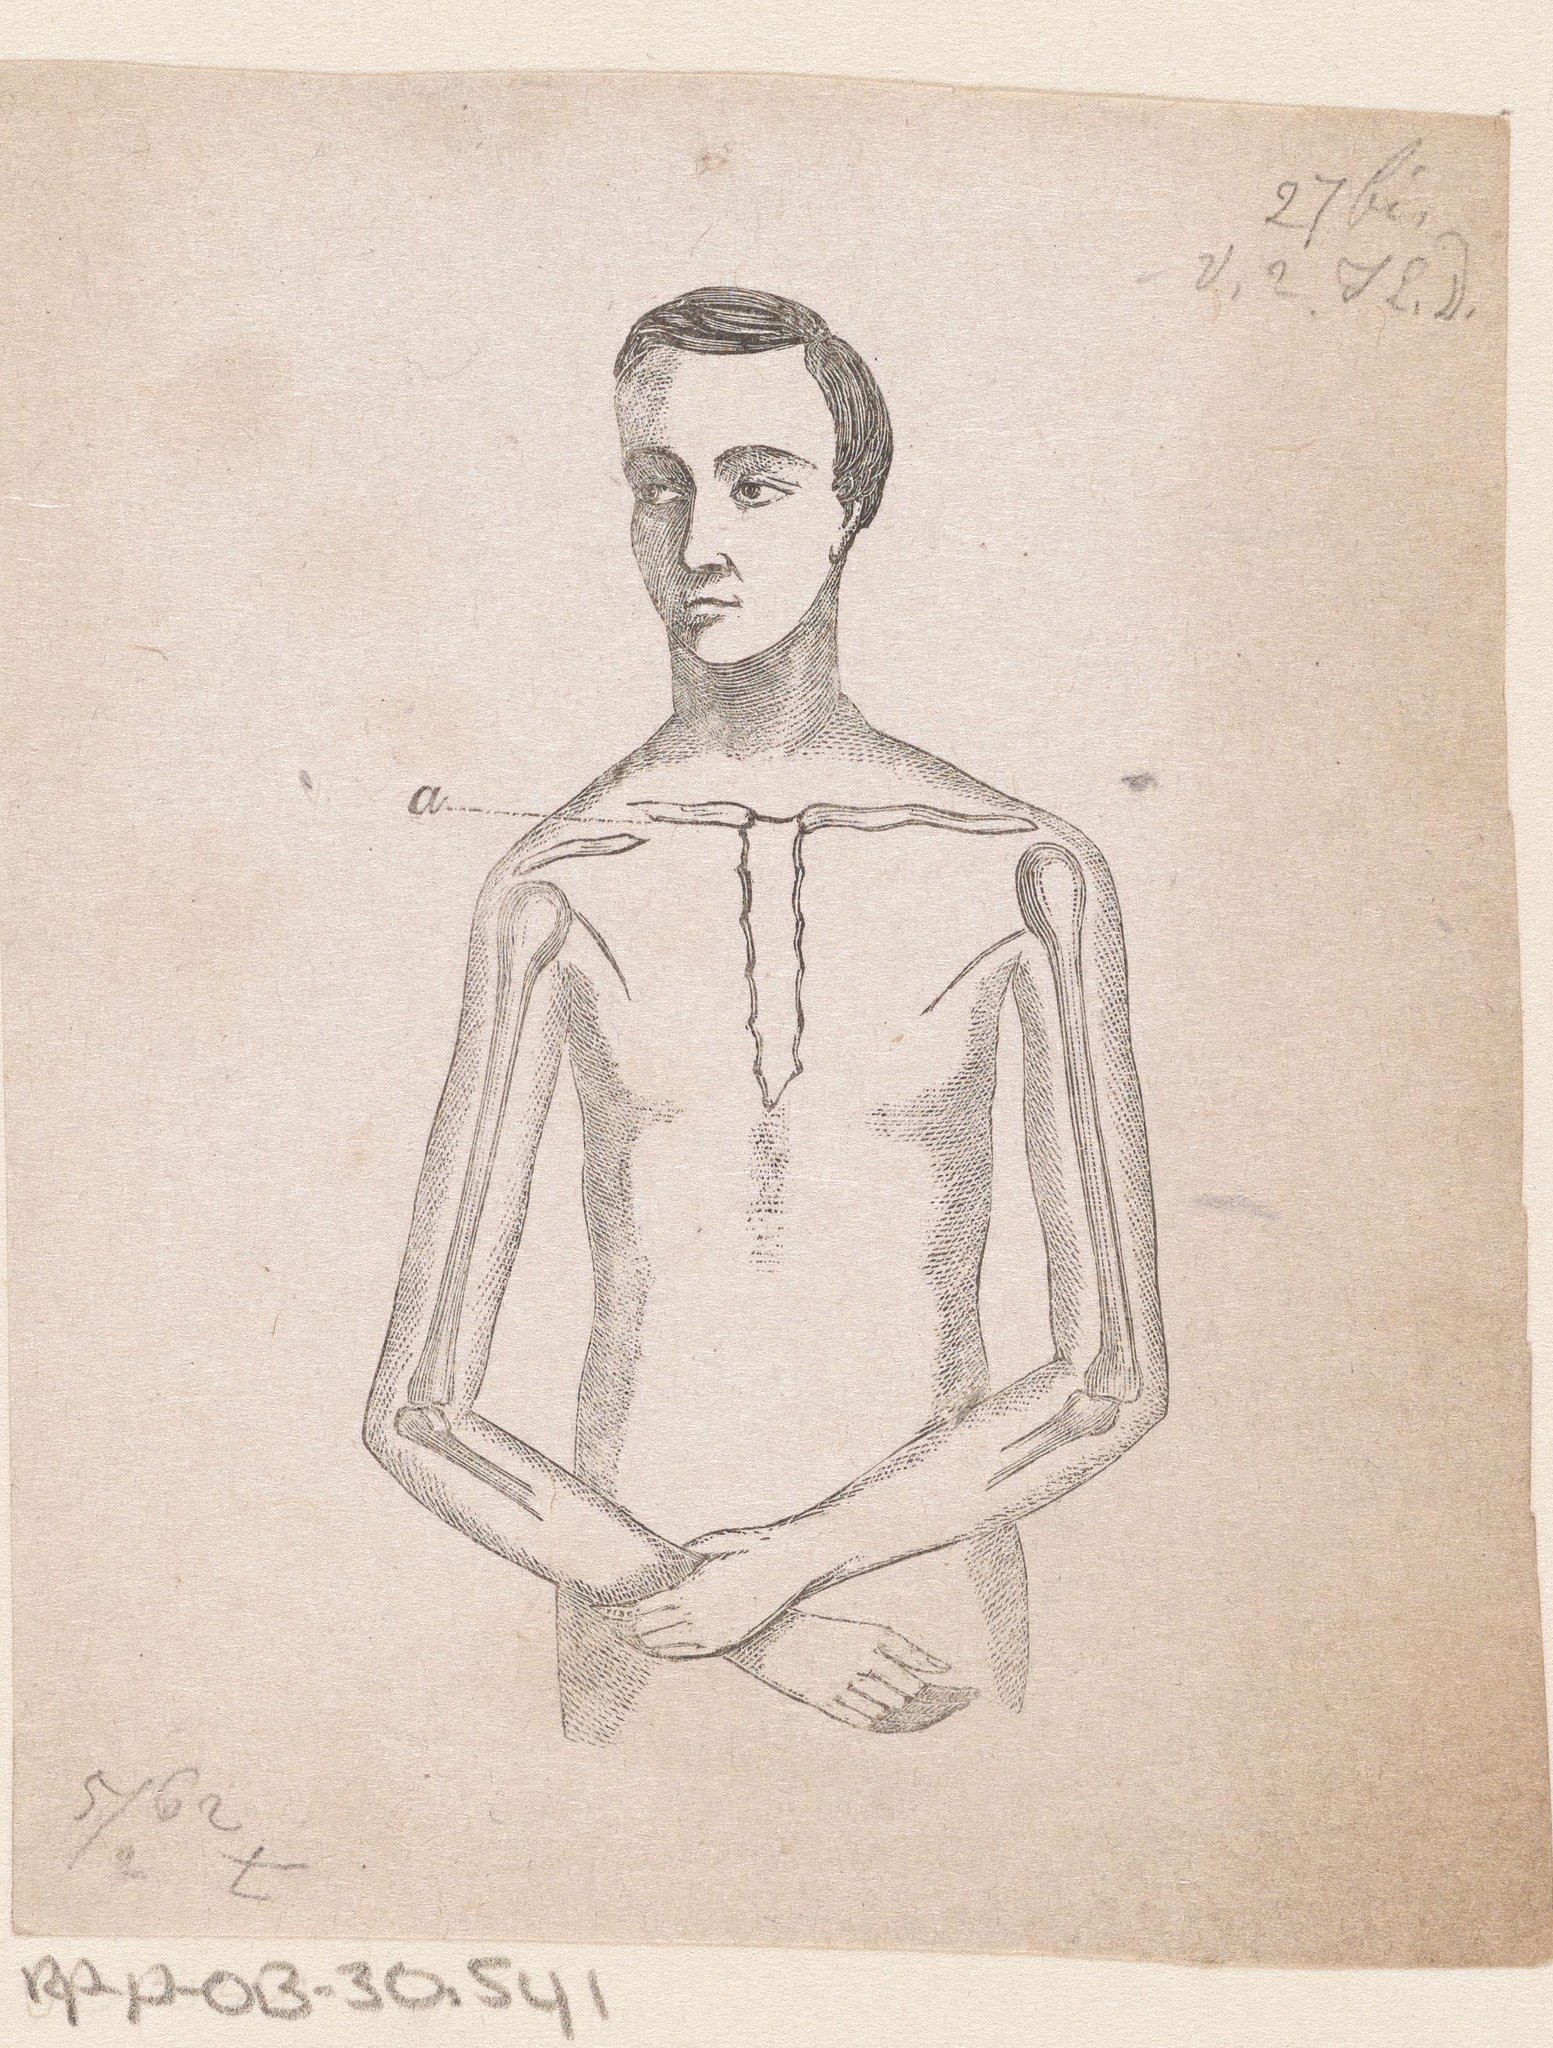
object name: print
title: Man met een breuk in het sleutelbeen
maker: isaac weissenbruch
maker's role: print maker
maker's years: 1826-1912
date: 1836-1912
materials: paper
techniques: engraving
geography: netherlands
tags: clavicle, collar-bone, fractures of bones